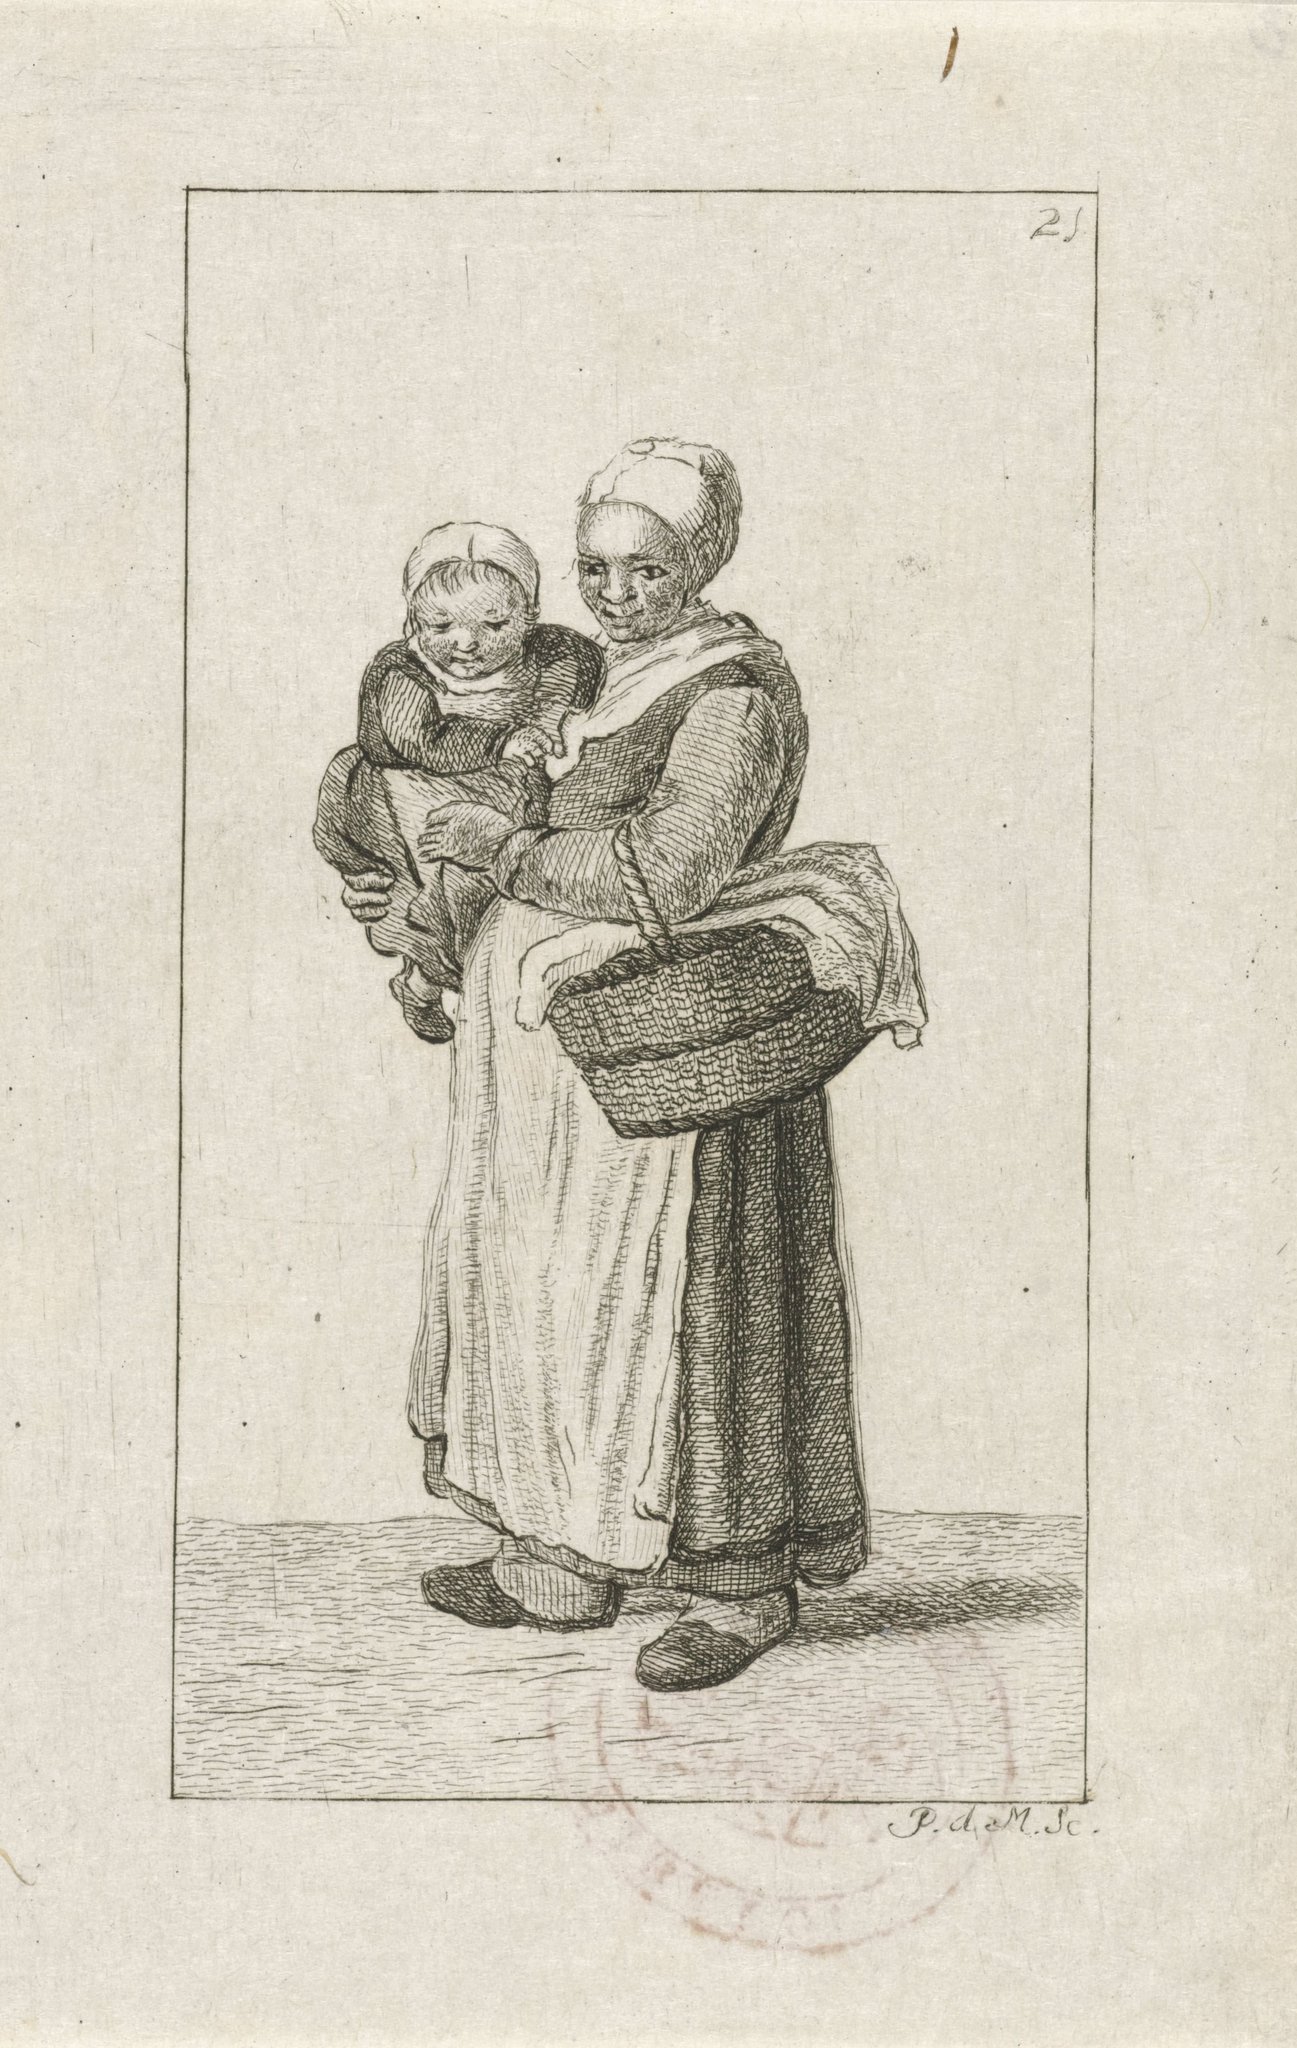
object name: print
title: Staande vrouw met kind op de arm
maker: pieter de mare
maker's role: print maker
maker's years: 1758-1796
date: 1779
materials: paper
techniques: etching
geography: leiden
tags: parents with their children, mother and baby or young child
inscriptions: collector's mark: Lugt 240